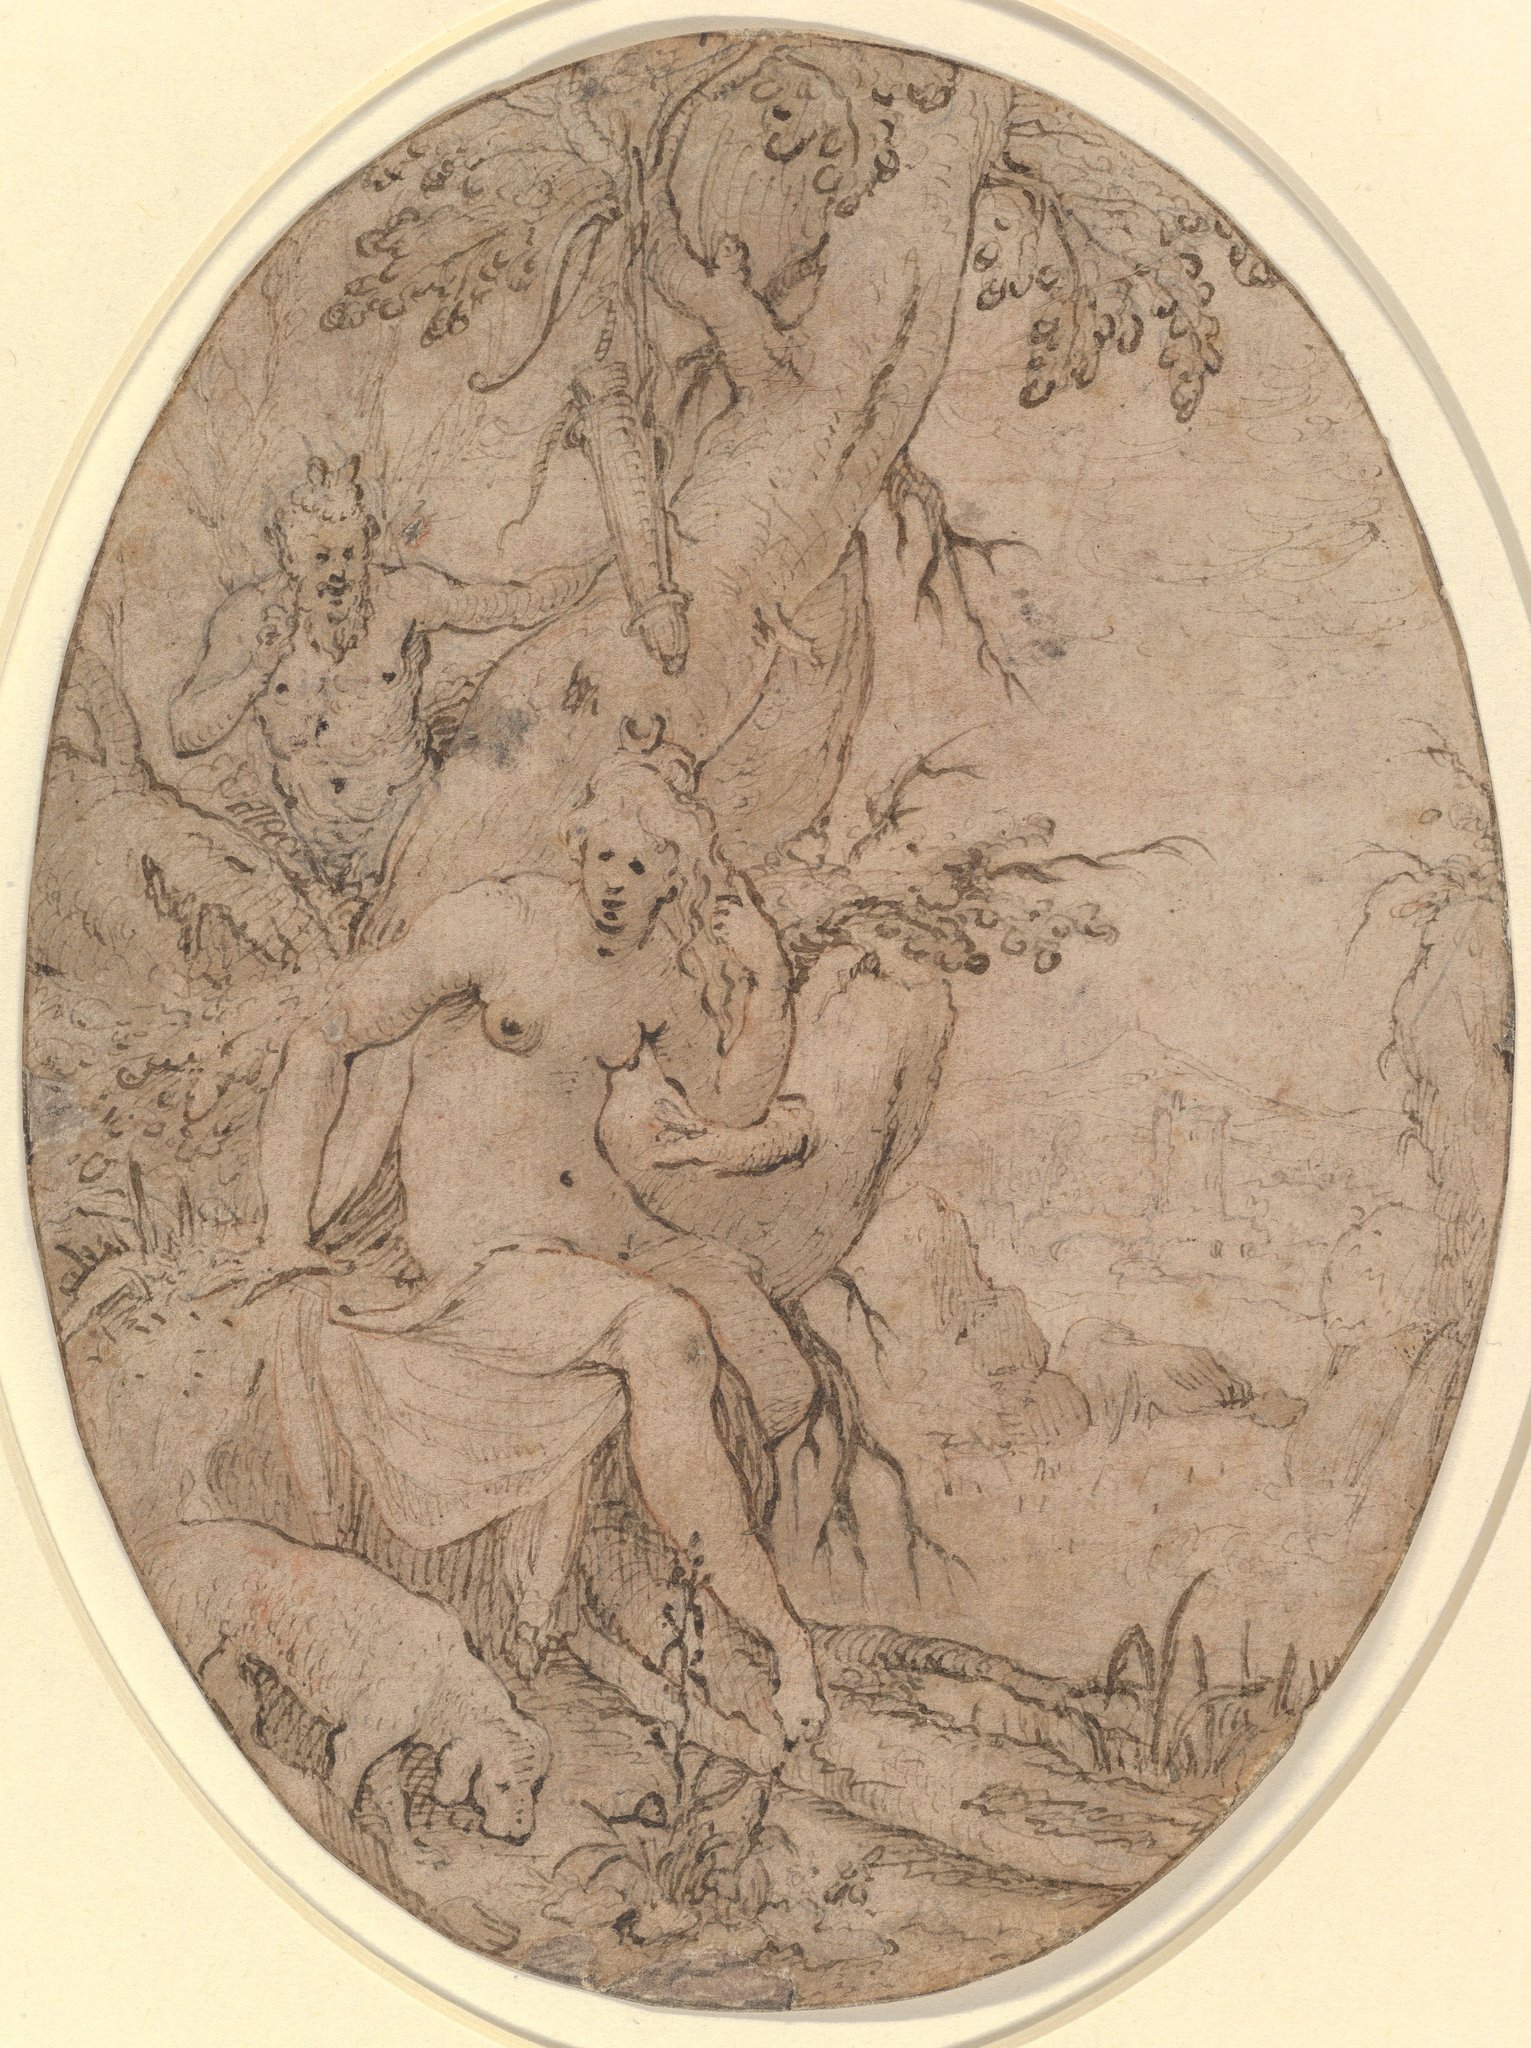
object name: drawing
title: Diana and a Leering Satyr in a Forest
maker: paulus willemsz. van vianen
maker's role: artist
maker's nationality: netherlandish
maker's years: 1565-1619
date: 1600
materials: chalk, ink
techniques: pen, wash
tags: diana,satyrs,dogs,forests